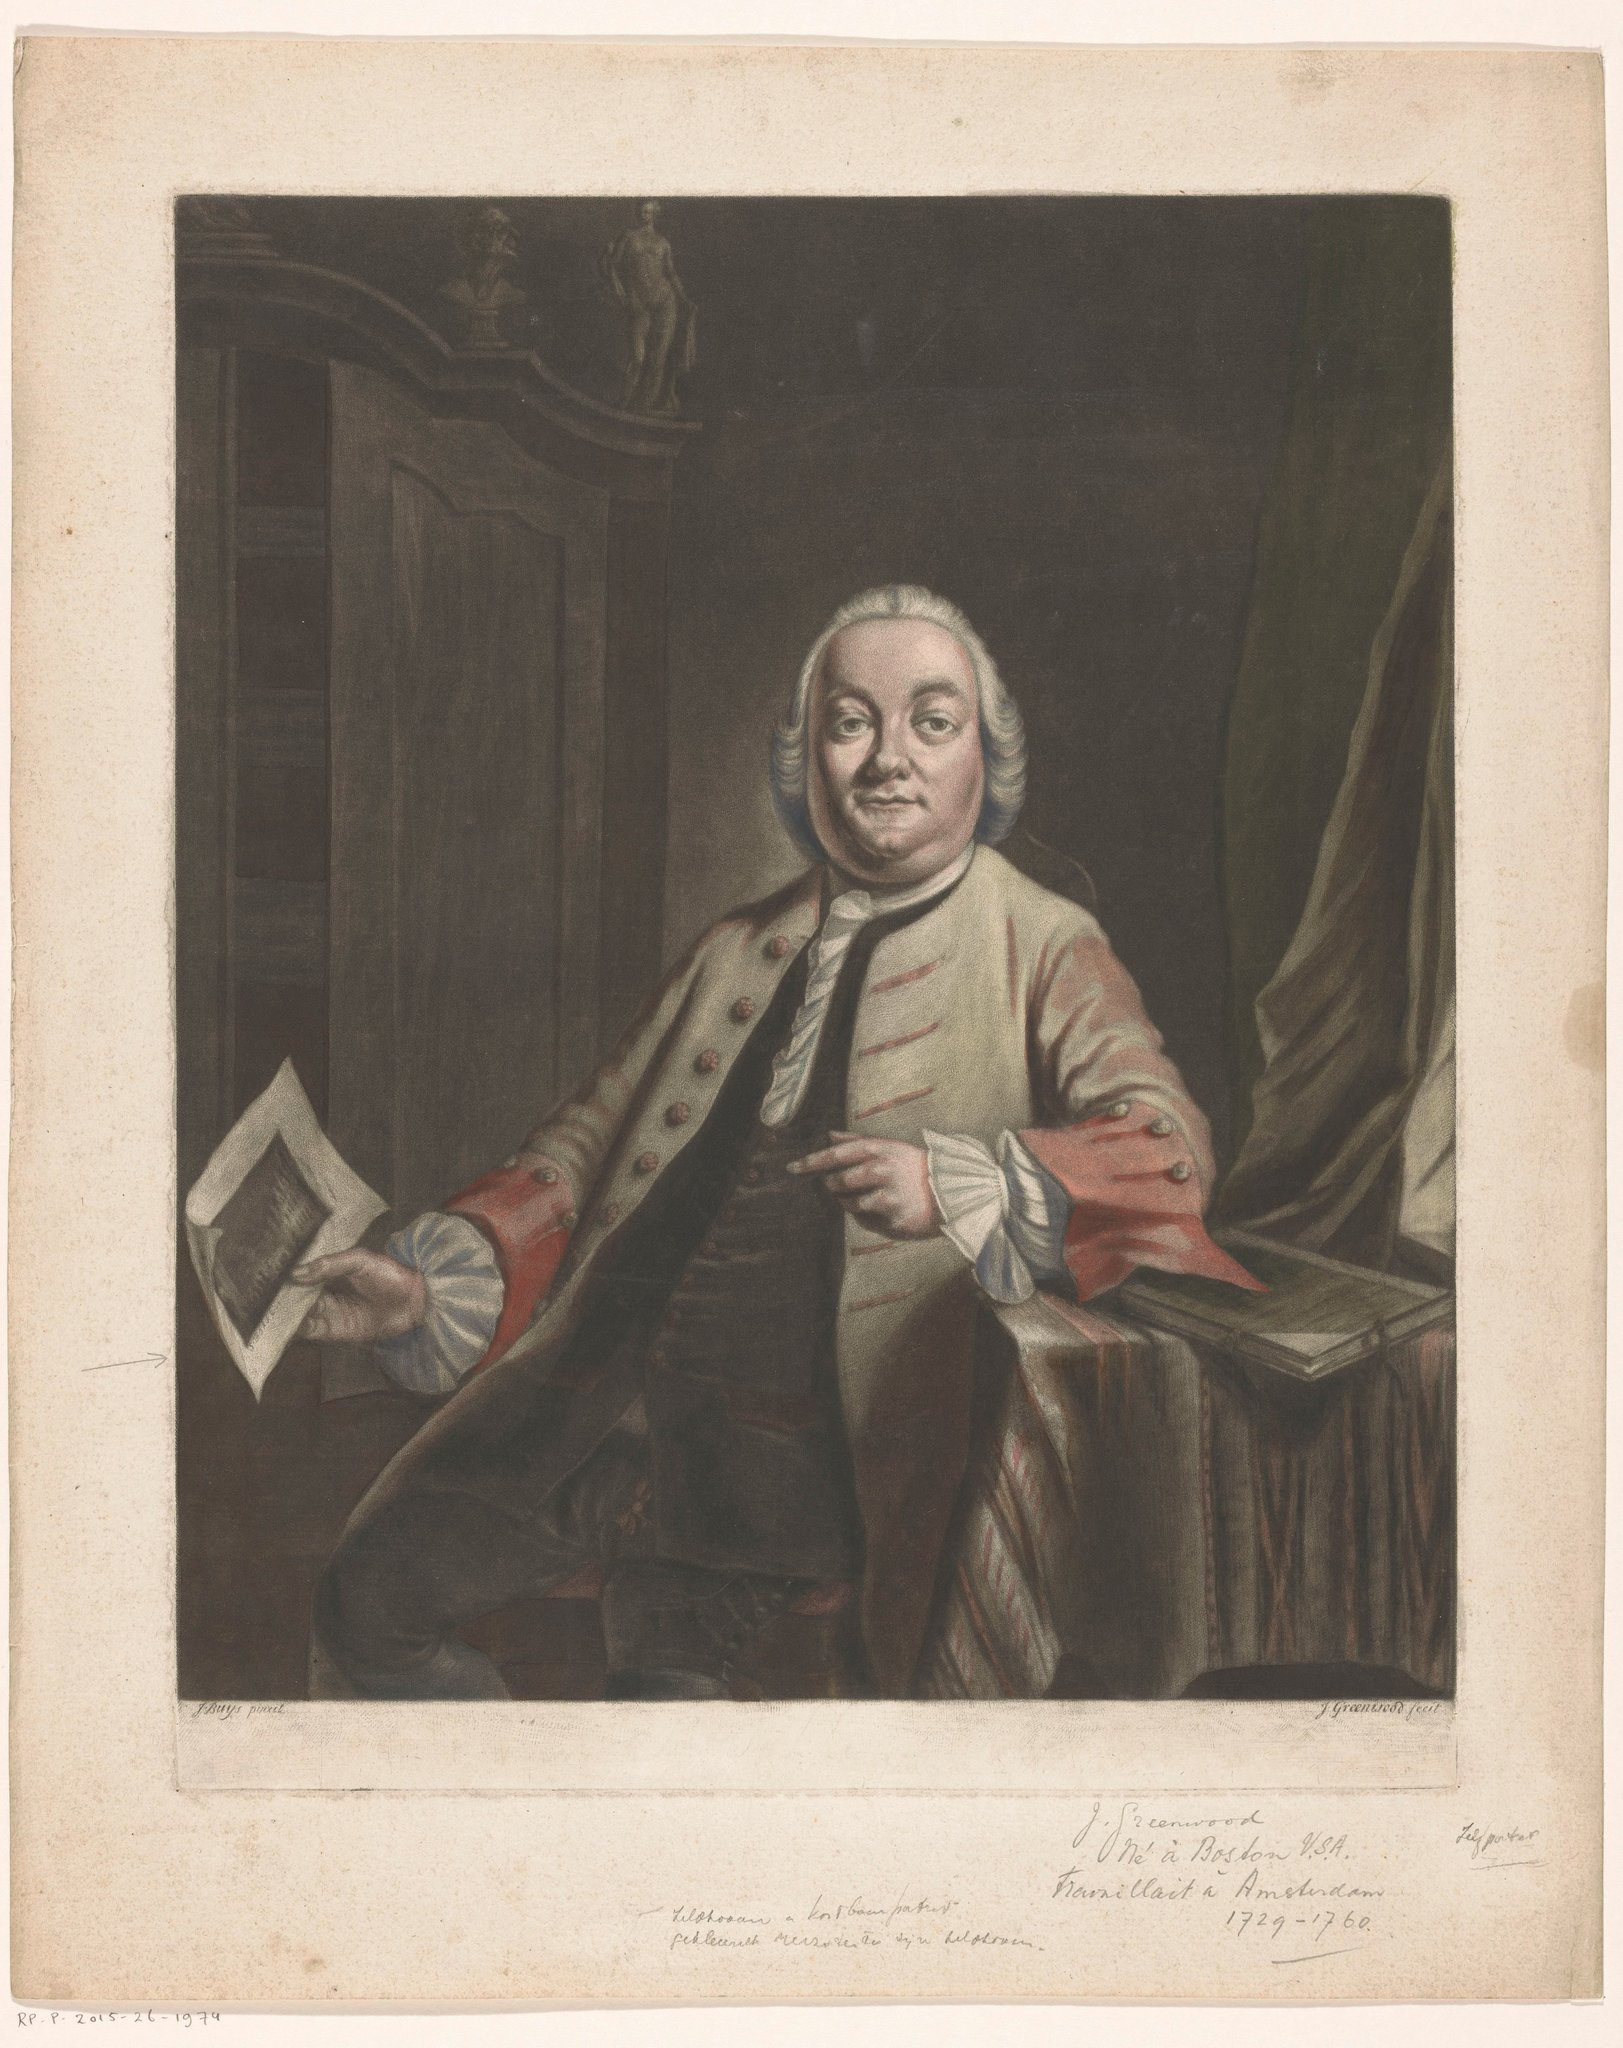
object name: print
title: Portret van Simon Fokke met in zijn hand de prent van de plundering van het huis van Gerrit Hagedooren, 1751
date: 1751-1792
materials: paper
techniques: hand coloring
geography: northern netherlands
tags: draughtsman, simon fokke, engraver, etcher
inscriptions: collector's mark: Lugt 4779, collector's mark: Lugt 2228, collector's mark: Lugt 4780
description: Portret van de prentmaker Simon Fokke zittend aan een tafel. Hij houdt in zijn rechterhand een afdruk van de prent van de plundering van het huis van de wijnkoper Gerrit Hagedooren (Hagedoorn) in de Bierstraat te Rotterdam in de avond van 17 augustus 1751.